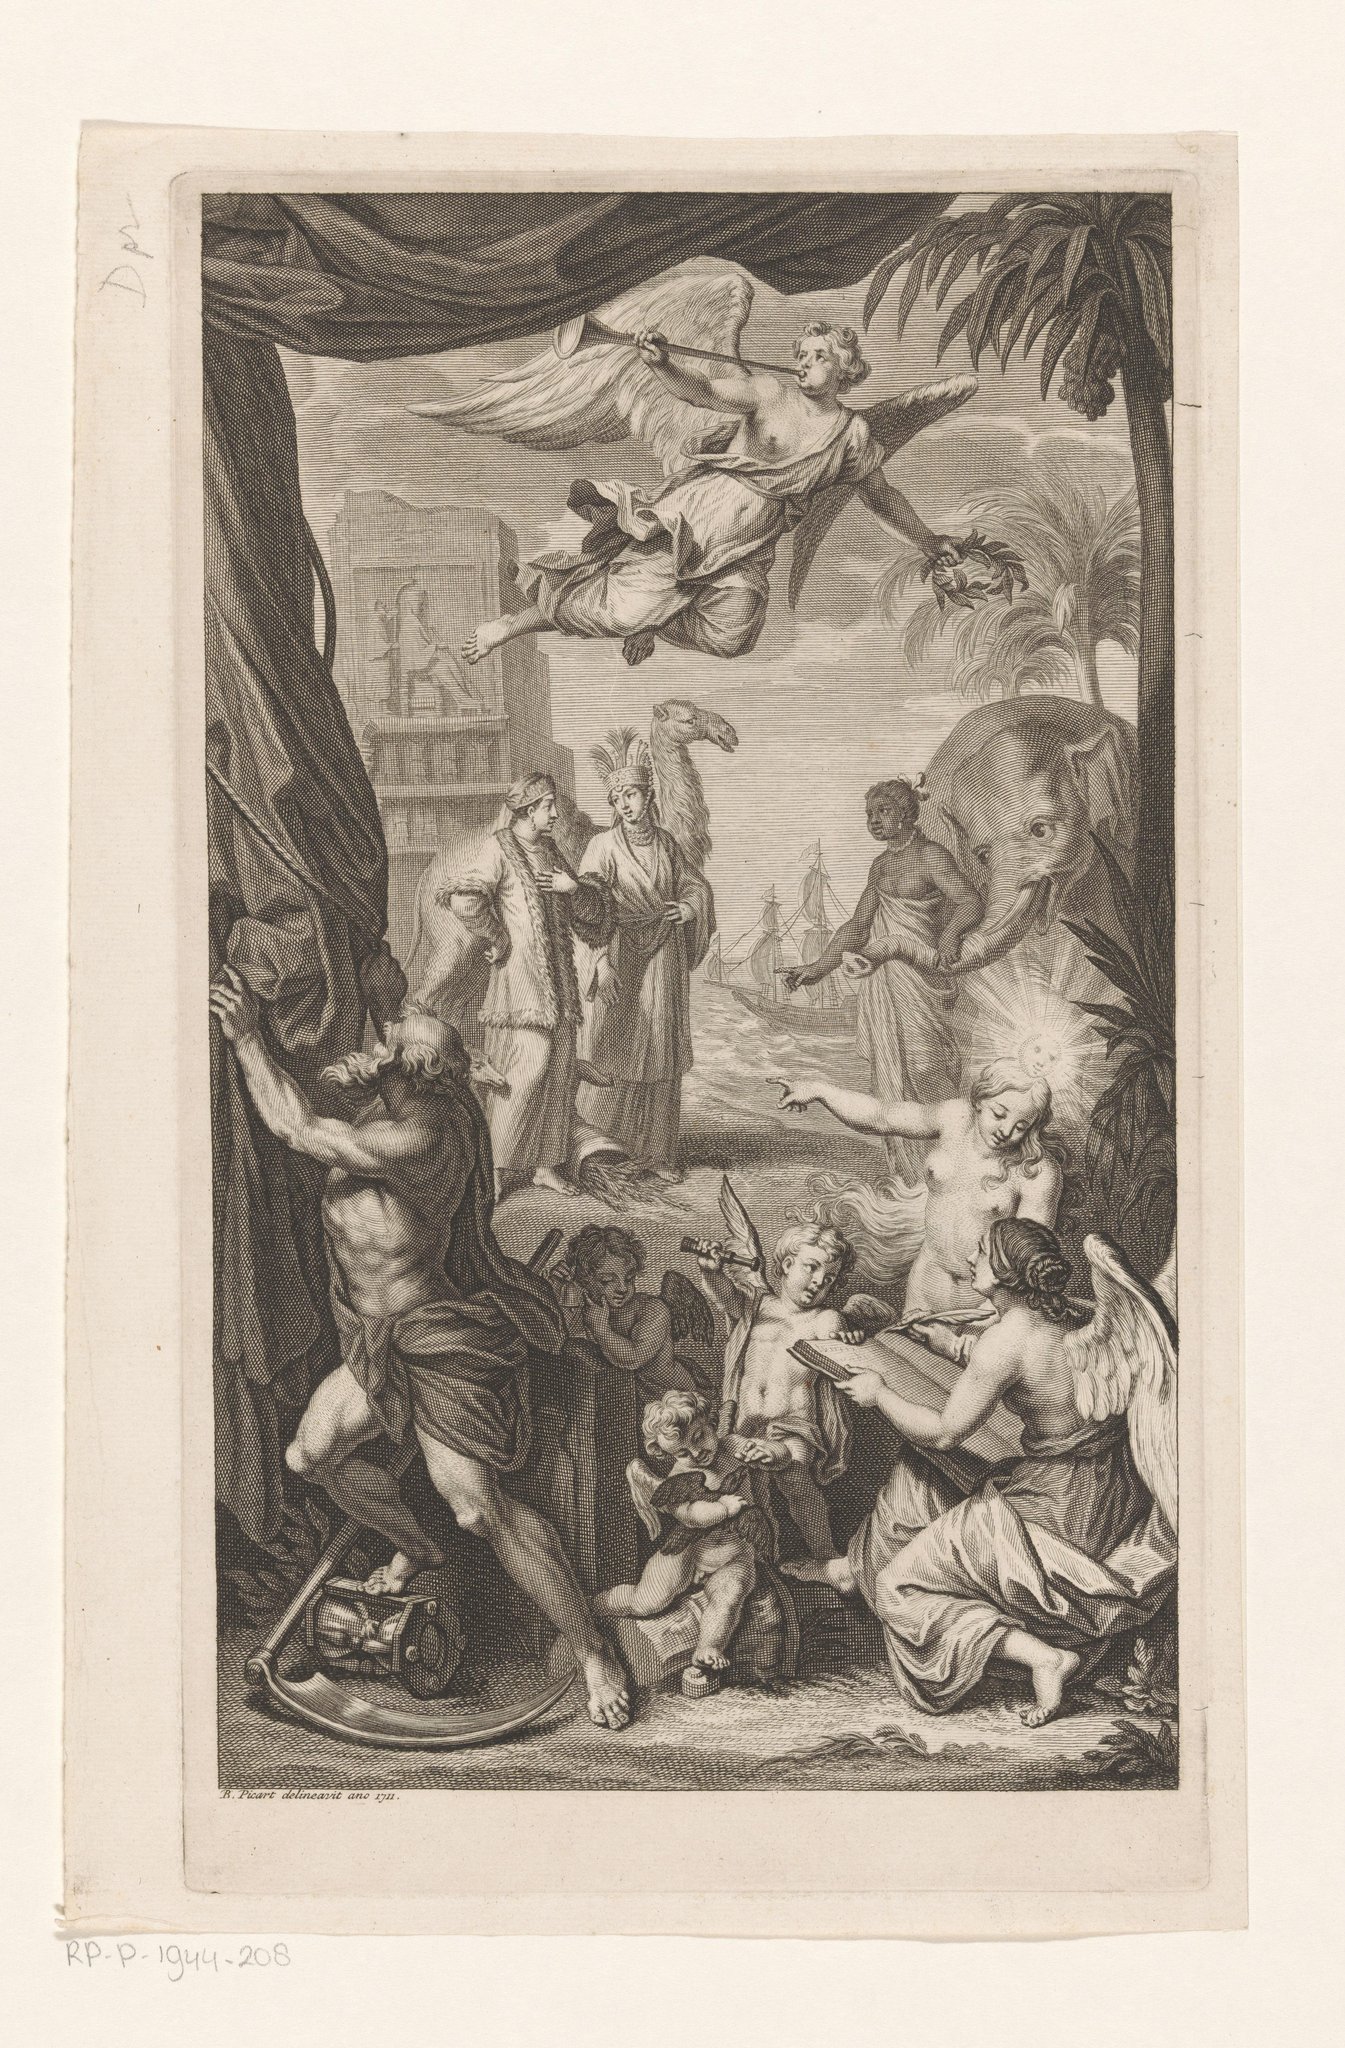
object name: print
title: Titelpagina voor: Cornelis de Bruyn, Reizen over Moskovie, door Persie en Indie, 1711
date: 1711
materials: paper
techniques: engraving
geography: amsterdam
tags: asia represented allegorically; 'asia' (ripa), writing and letters, fame; 'fama', 'fama buona', 'fama chiara' (ripa), father time, man with wings and scythe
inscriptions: collector's mark: Lugt 2760, collector's mark: Lugt 2228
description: Vader Tijd met zeis en zandloper houdt draperieën opzij. Een gevleugelde vrouw schrijft in een boek. Zij wordt gewezen op de Aziatische figuren, dieren en het landschap in de achtergrond door een vrouw met de zon op het hoofd. Naast haar drie putti. Aan de bovenzijde vliegt Faam met bazuin en lauwerkrans.